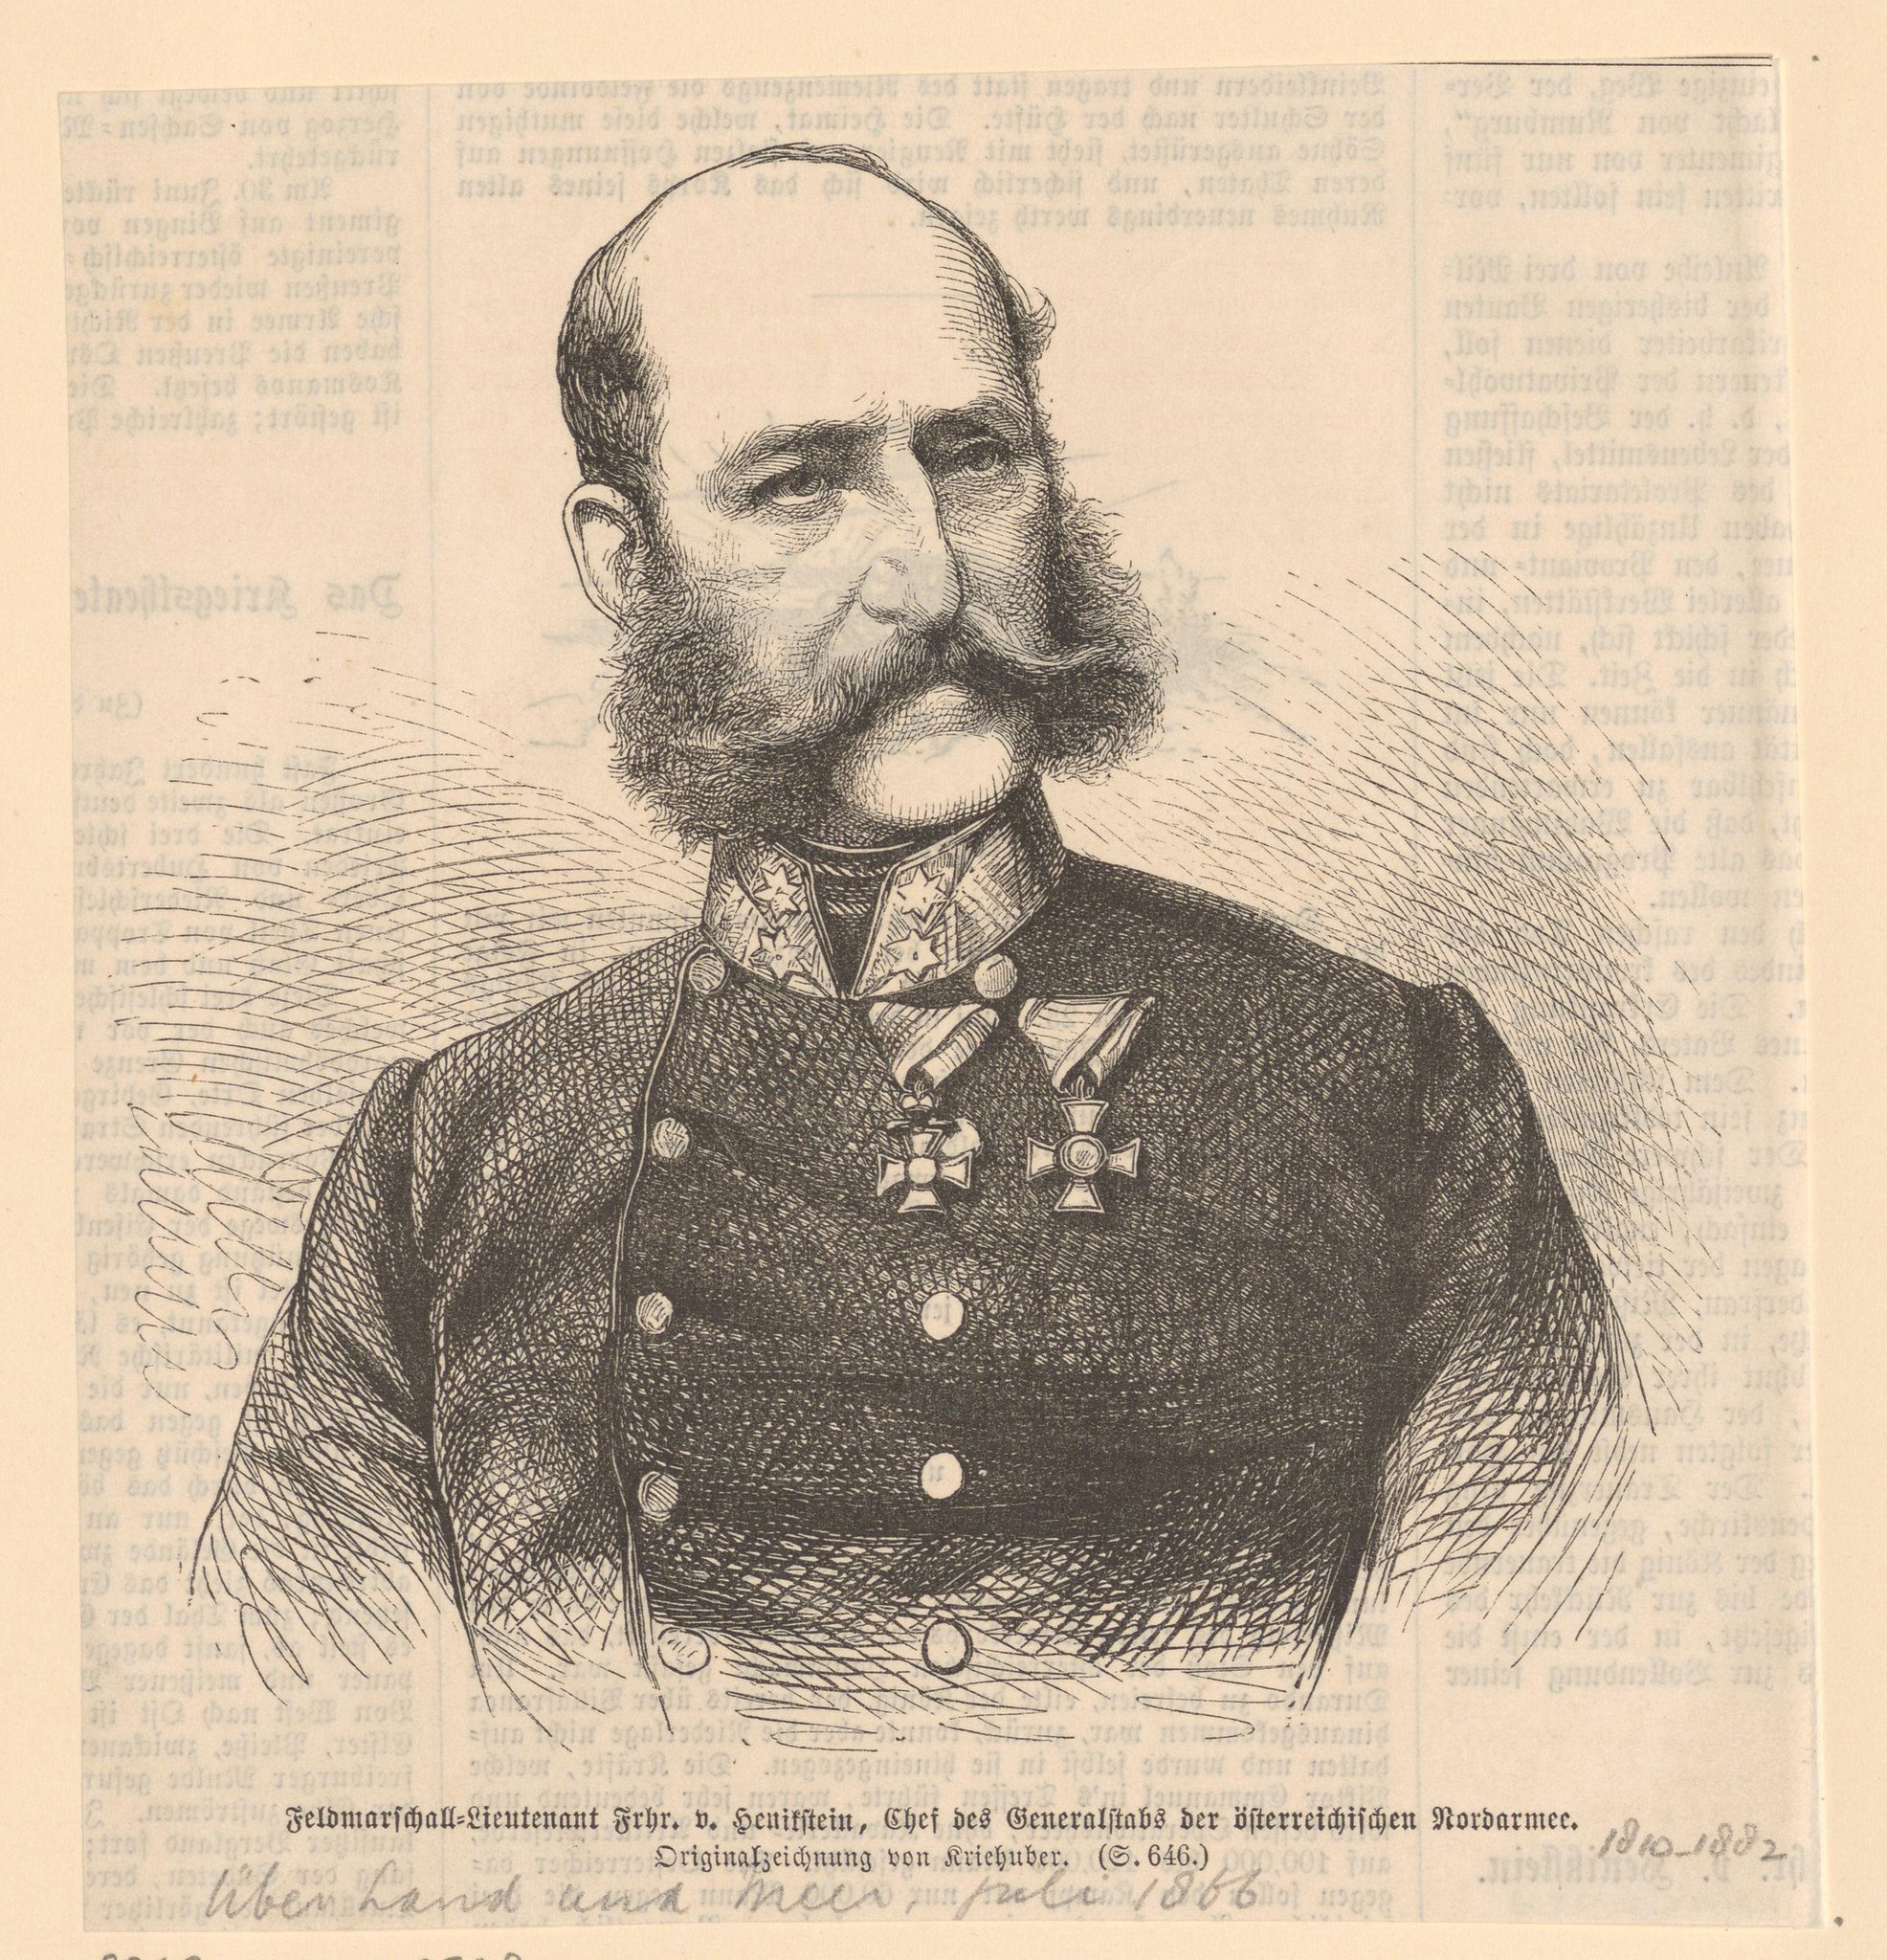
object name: print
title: Portret van Alfred von Henikstein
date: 1866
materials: paper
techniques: letterpress printing, engraving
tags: historical persons, officer, medals and other marks of military honour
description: Prent uit: Über Land und Meer, nr. 41, juli 1866.